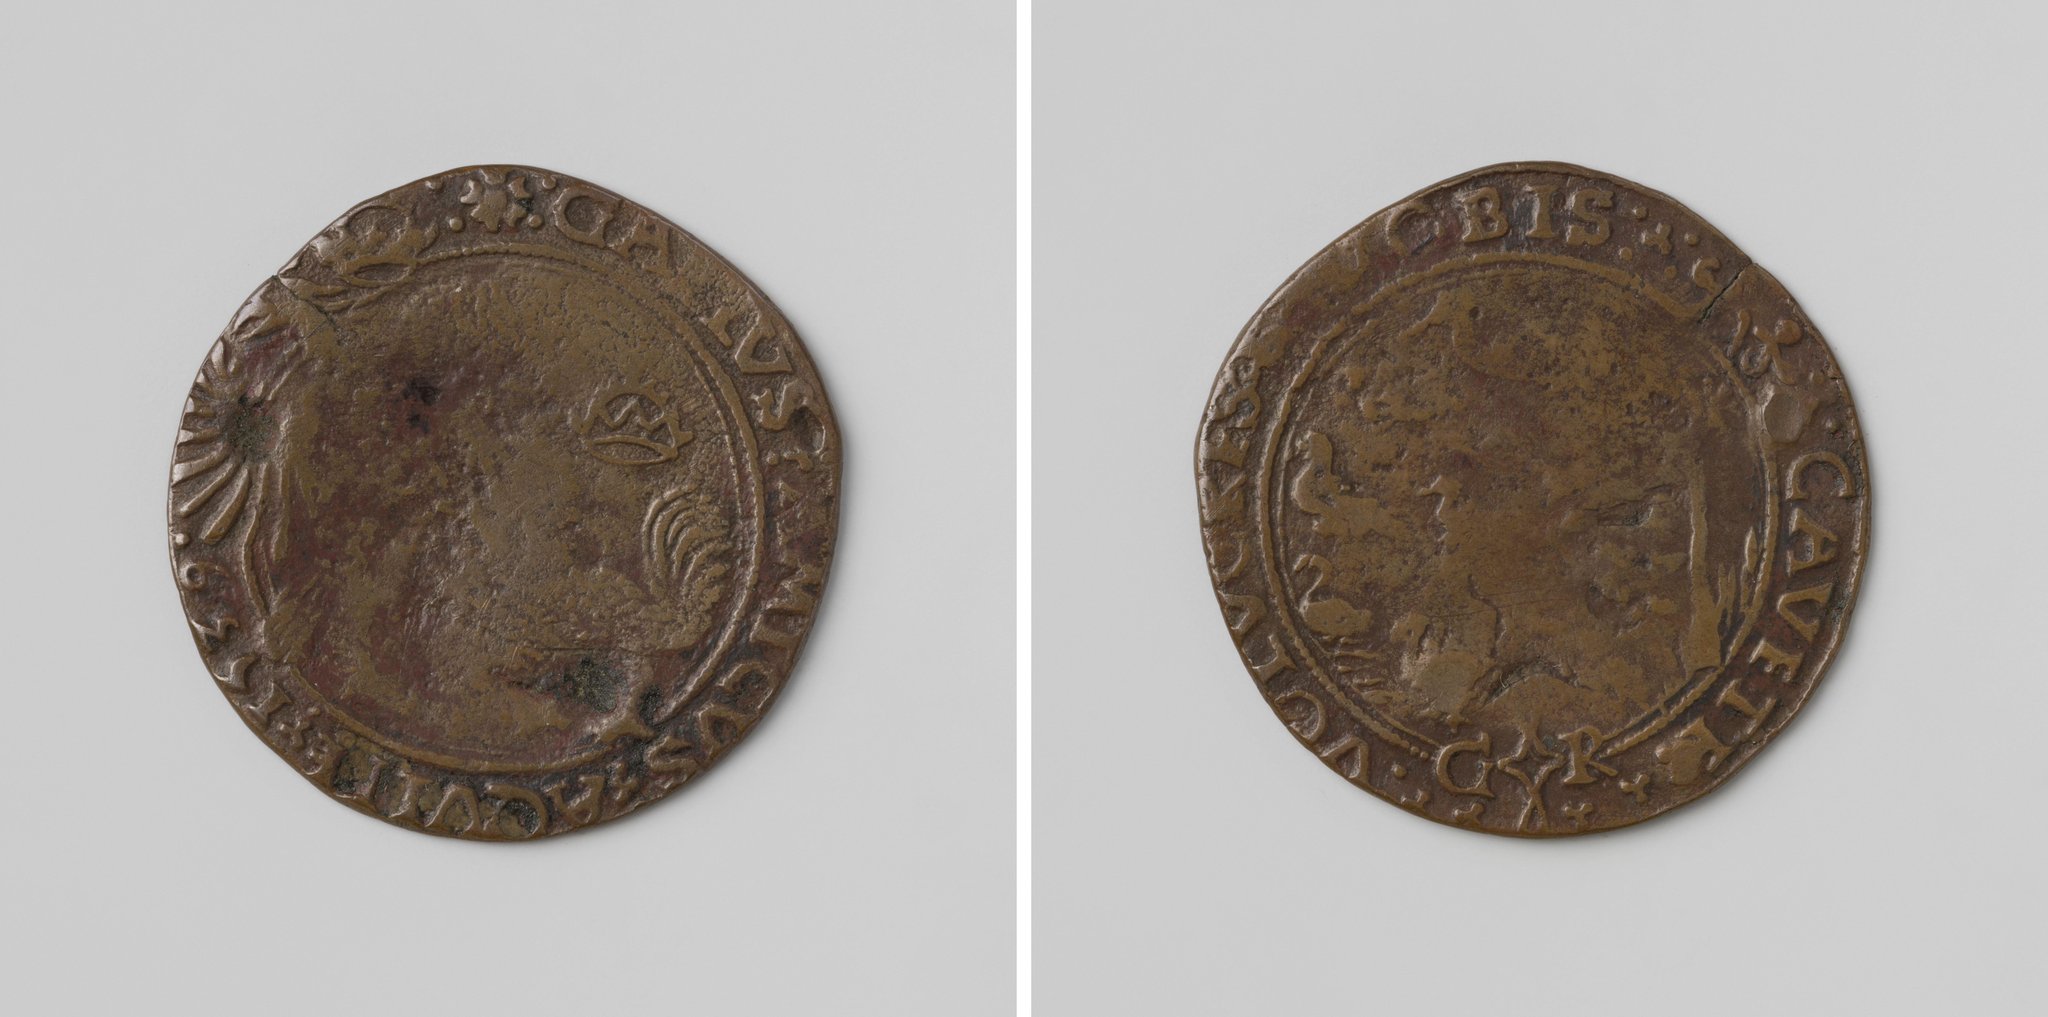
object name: jeton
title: Verdrag van Toledo tussen Karel V, Duits keizer en Frans I, koning van Frankrijk, rekenpenning ten behoeve van Gerrit van Renoy, auditeur van de rekenkamer van Holland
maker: Anonymous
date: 1539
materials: copper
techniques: striking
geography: netherlands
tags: frans i van valois-angoulême (koning van frankrijk), charles v (holy roman emperor and king of spain), holland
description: Koperen penning. Voorzijde: adelaar en haan, ieder onder eigen kroon binnen omschrift. Keerzijde: vogels, geleid door een ooievaar boven monogram, bestaande uit letters G en R binnen omschrift